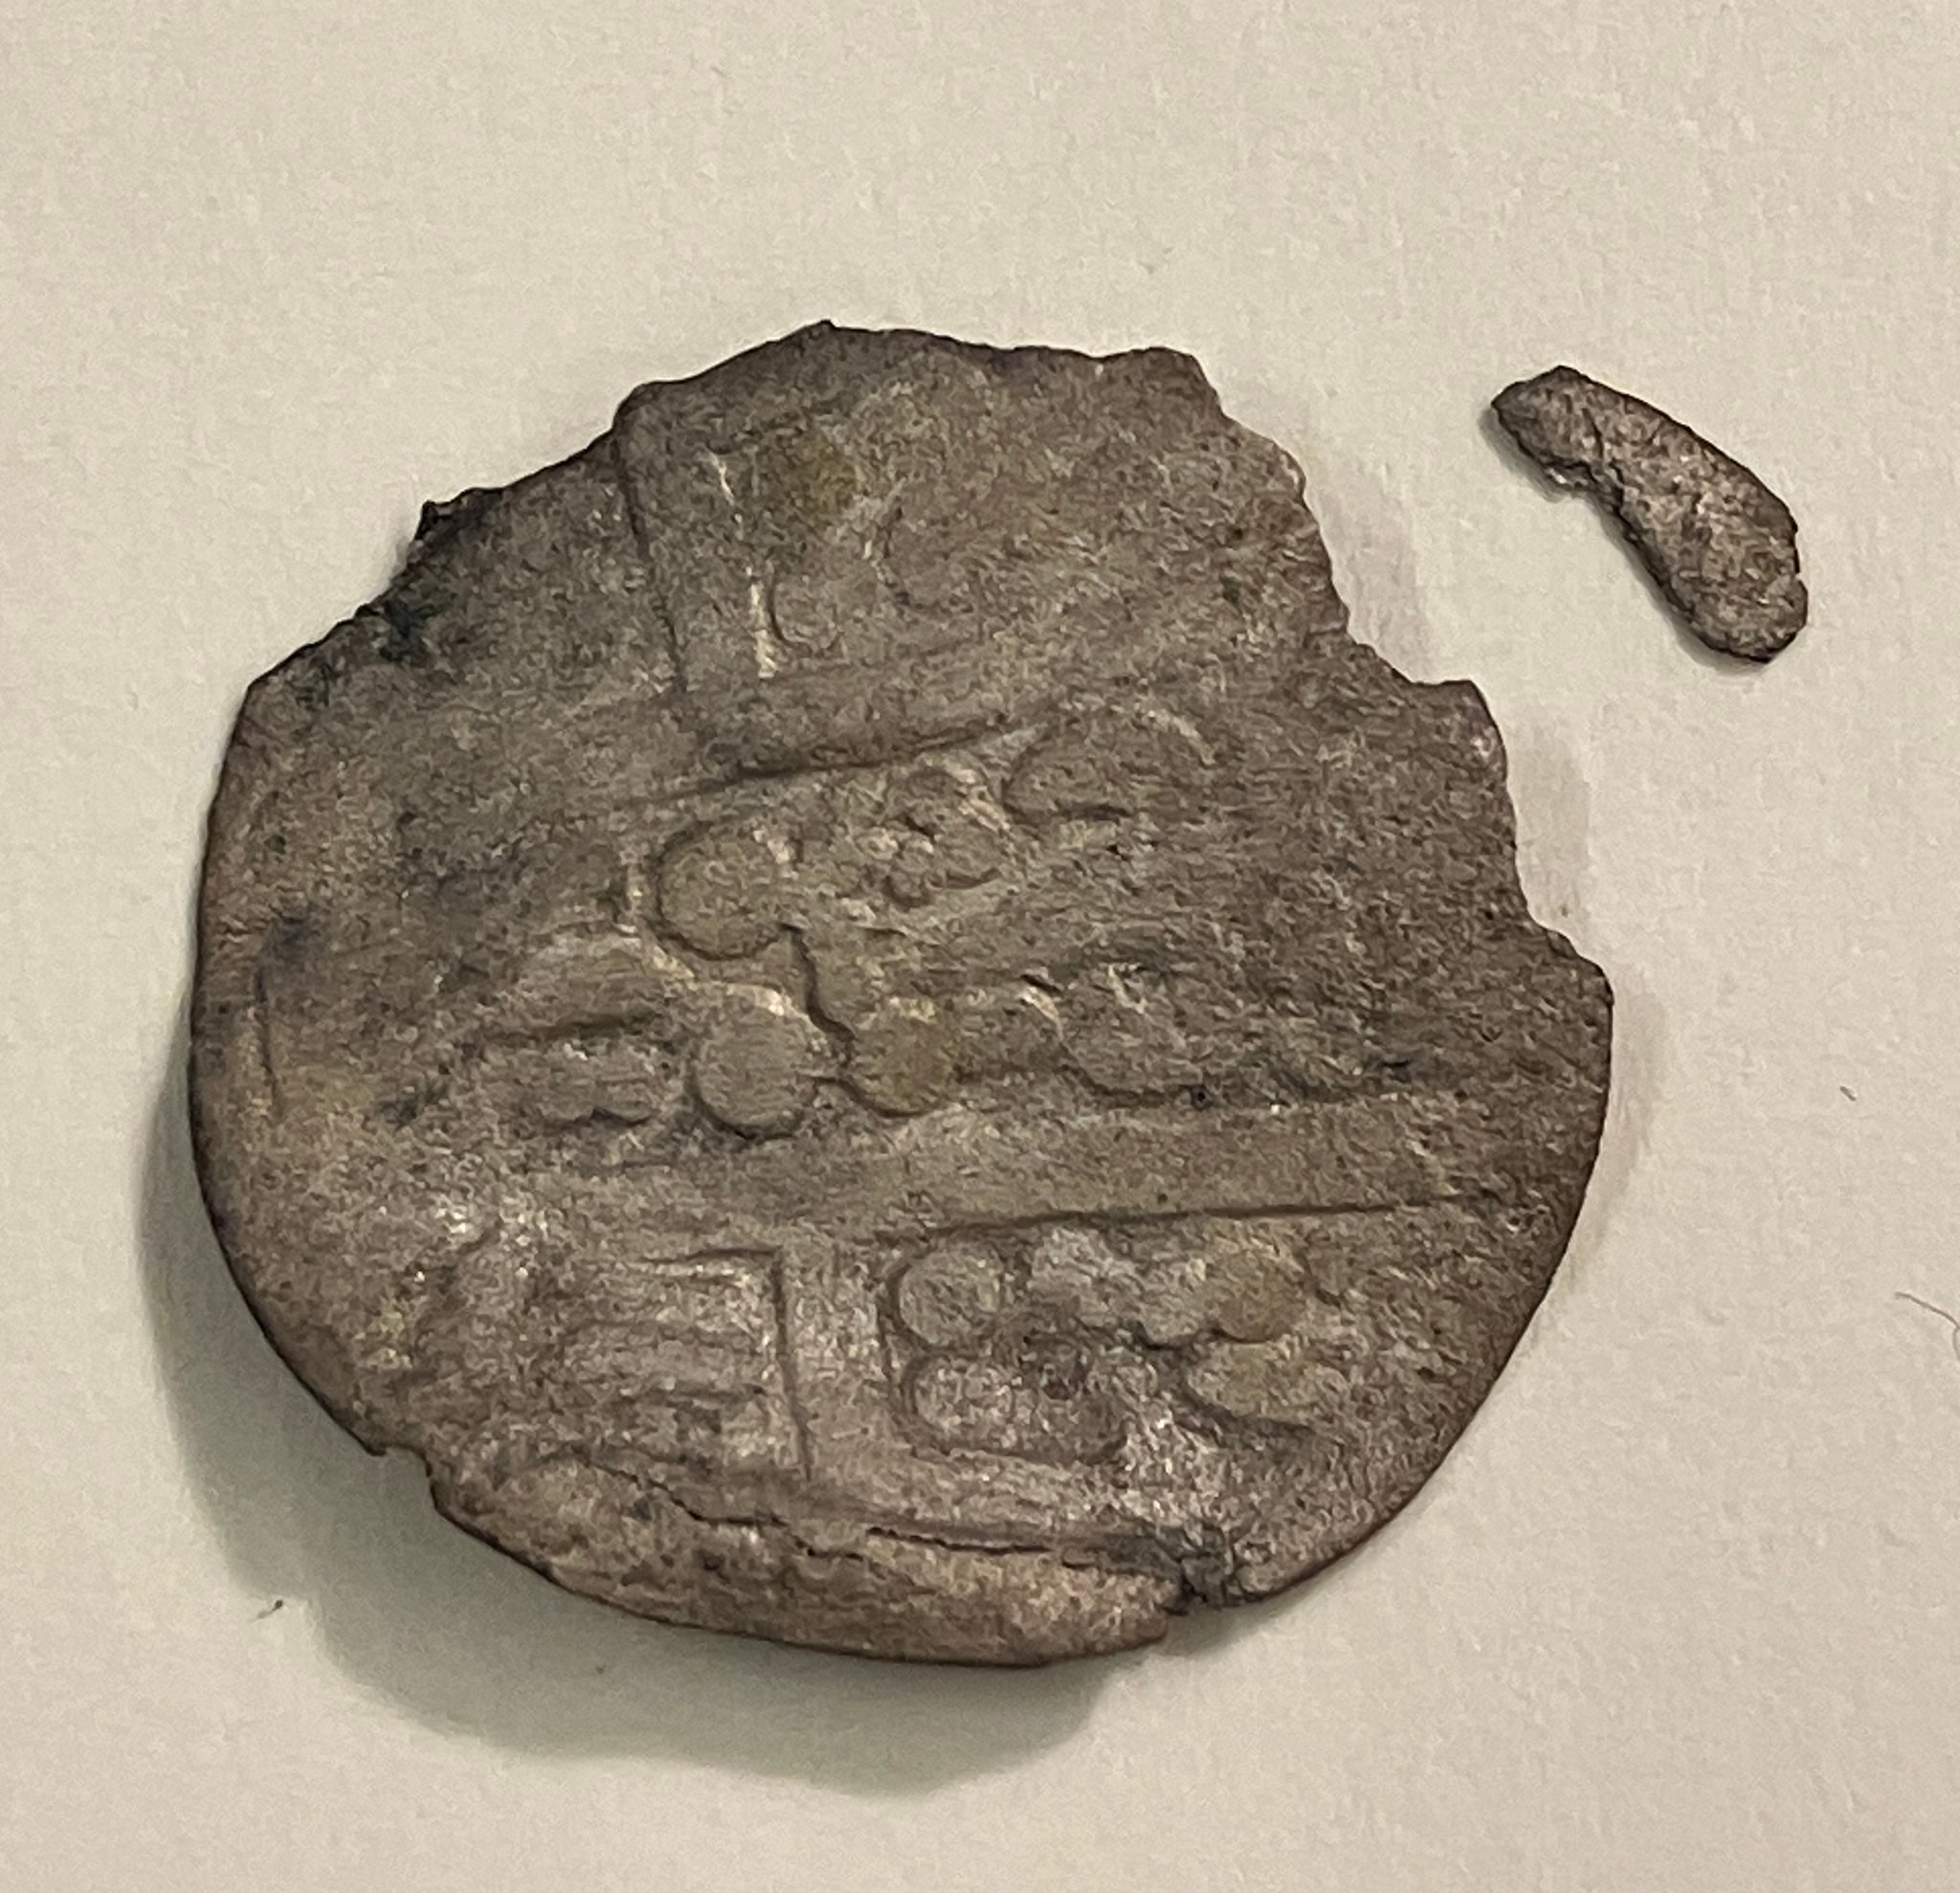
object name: coin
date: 401-1400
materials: silver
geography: iran